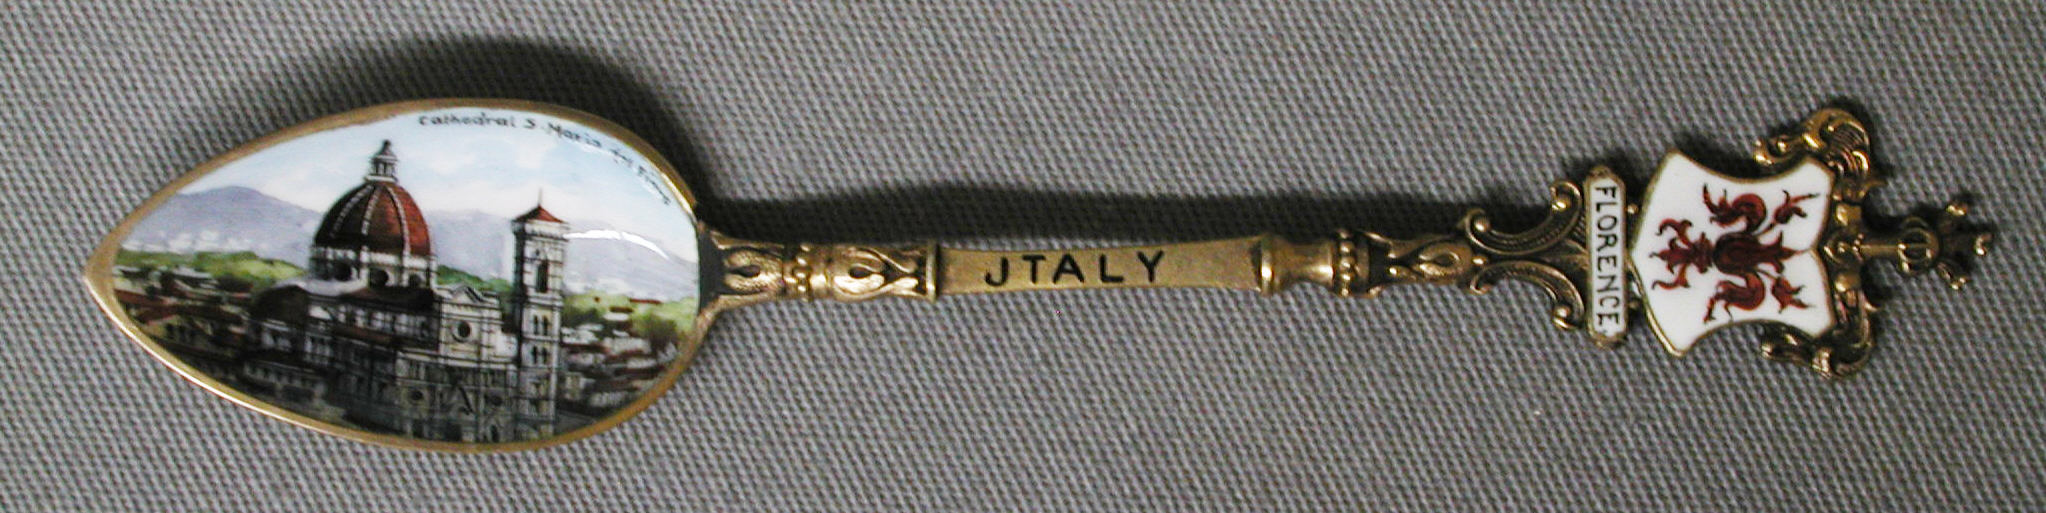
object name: souvenir spoon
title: Souvenir spoon with the view of Santa Maria del Fiore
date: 1867-1900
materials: enamel, silver gilt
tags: coat of arms